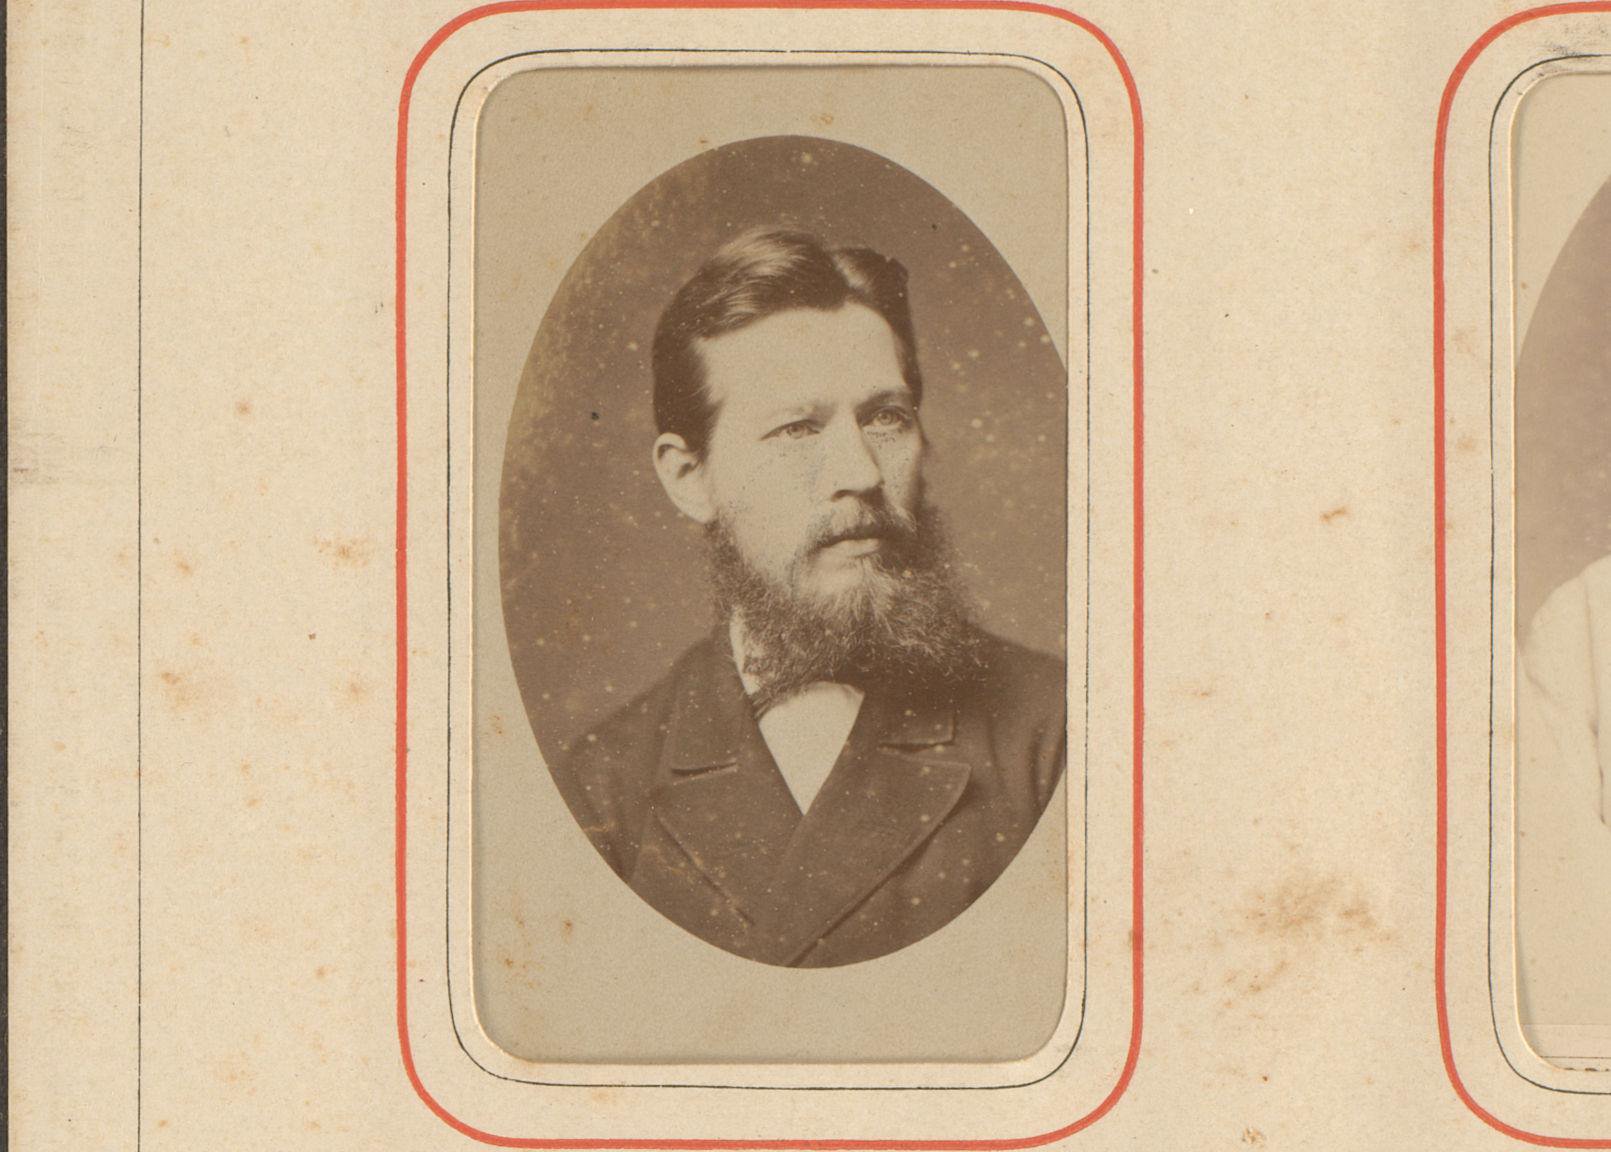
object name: carte de visite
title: Portret van een onbekende man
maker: johannes baer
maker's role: fotograaf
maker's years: 1840-1912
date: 1871-1891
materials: cardboard, paper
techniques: albumen print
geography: rotterdam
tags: anonymous historical person portrayed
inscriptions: address: ‘Schiedamsche Singel 55/ Rotterdam.’